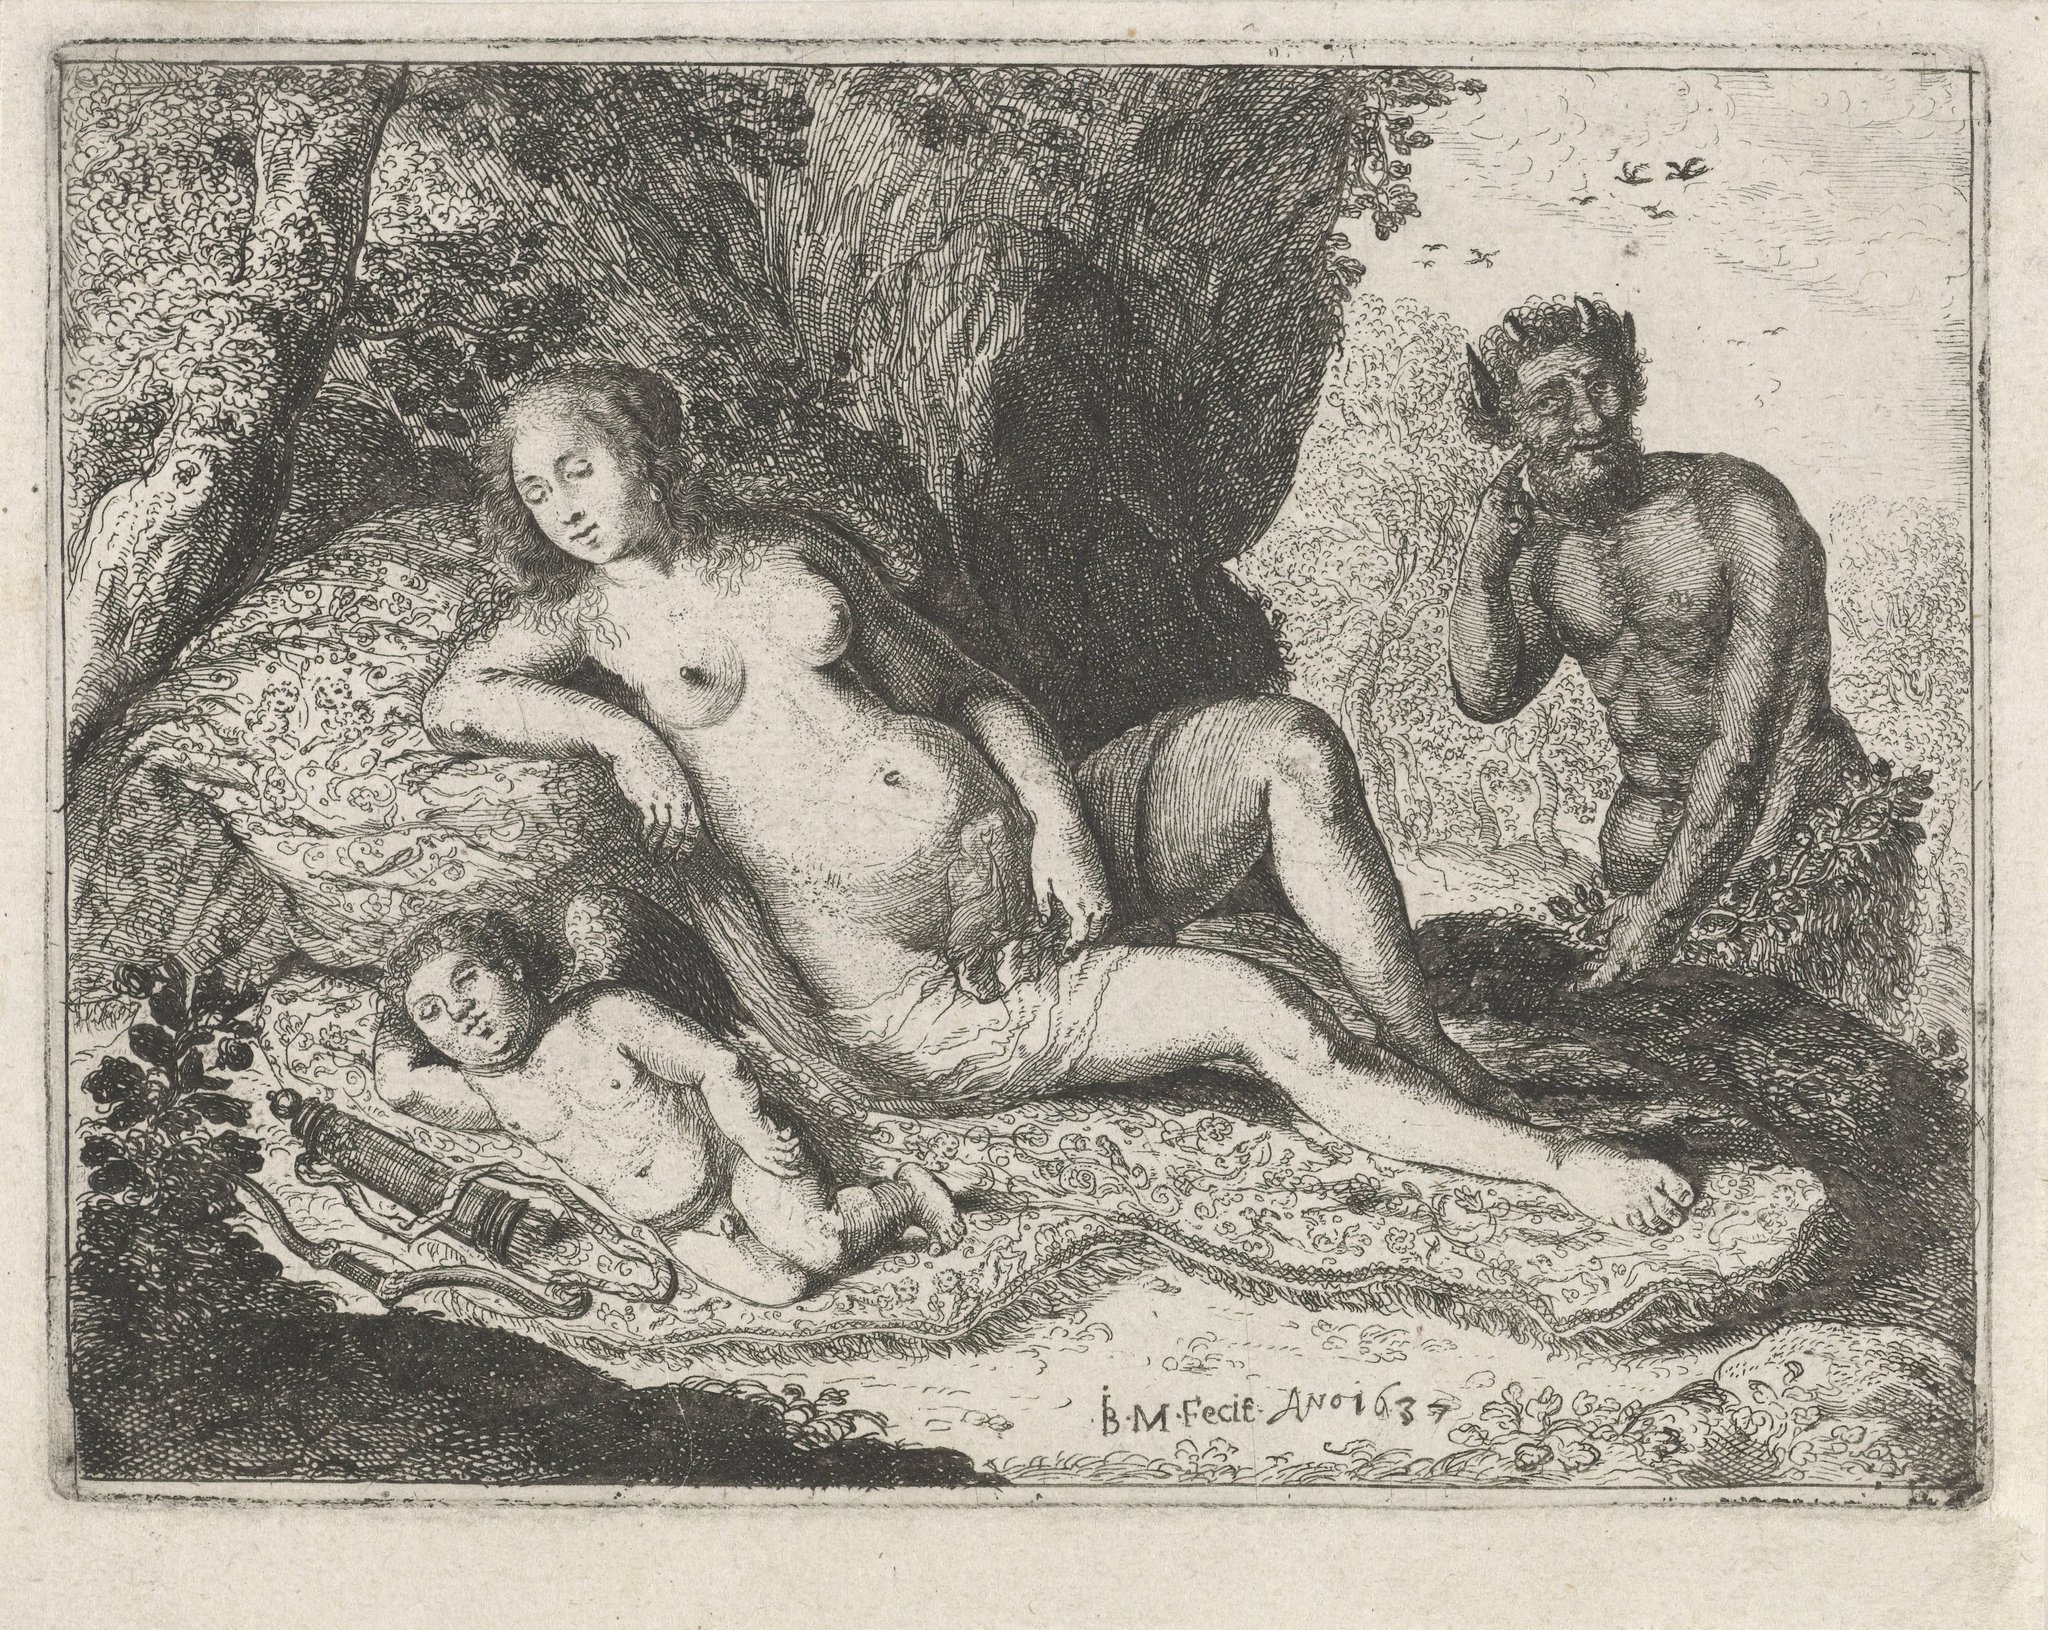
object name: print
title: Slapende Venus bespied door een sater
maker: jan barentsz. muyckens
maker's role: print maker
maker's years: 1595-1665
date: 1637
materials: paper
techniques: etching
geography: amsterdam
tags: venus asleep (+ variant), satyr(s) spying upon, sleeping cupid; possibly signifying a slackening of love's influence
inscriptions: collector's mark: Lugt 2228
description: De slapende Venus wordt bespied door een sater. Naast Venus ligt Amor te slapen, zijn pijlenkoker naast hem.